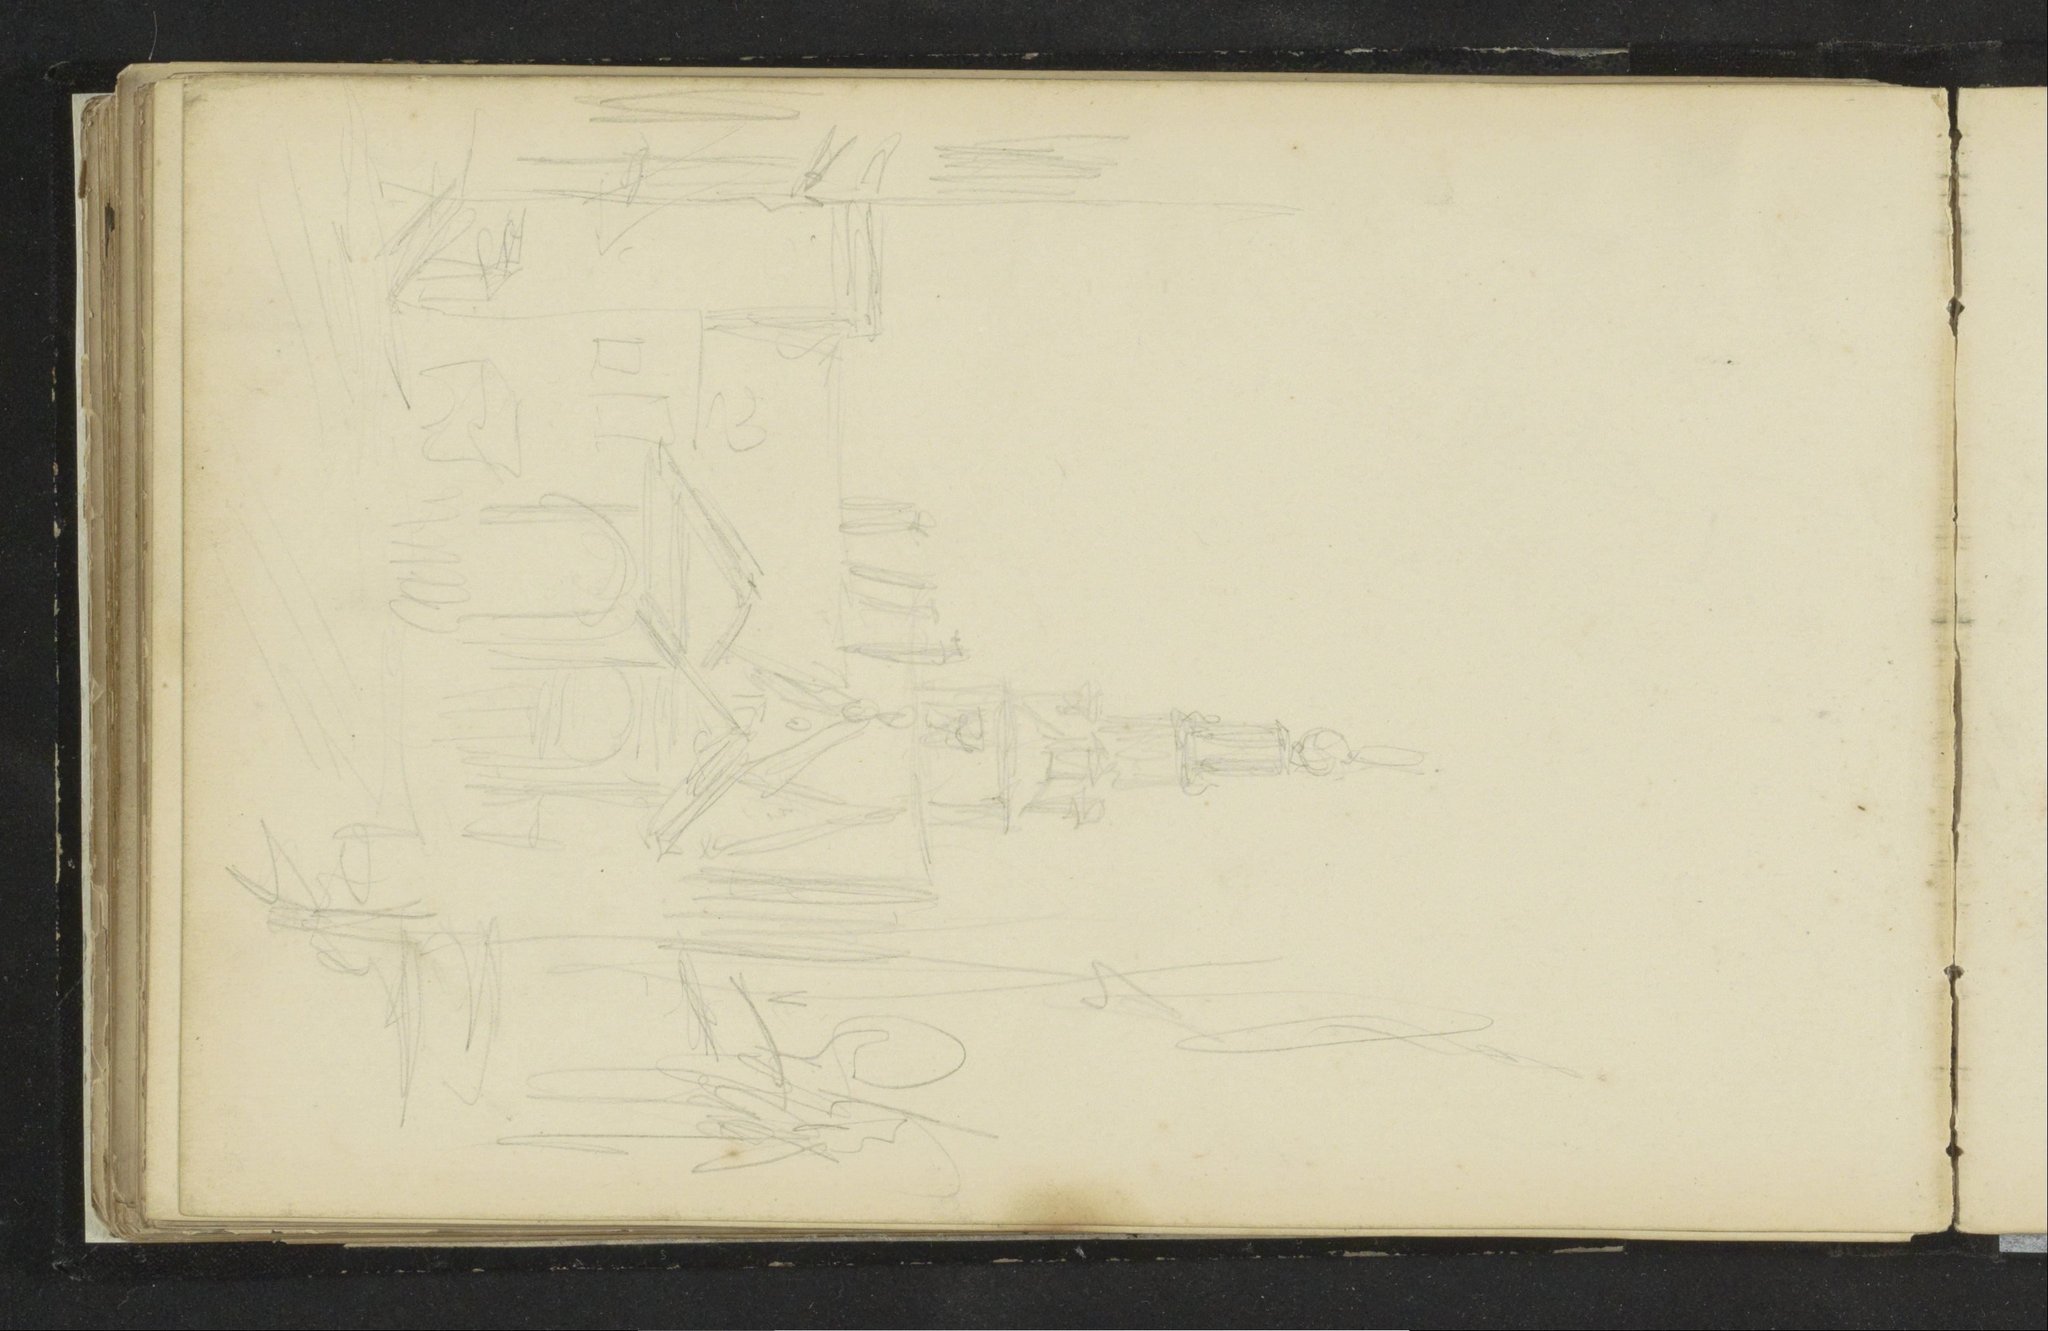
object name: sketchbook leaf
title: Stadsgezicht met een kerktoren, mogelijk in Amsterdam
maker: cornelis springer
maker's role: draughtsman, painter, print maker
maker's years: 1817-1891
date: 1846-1882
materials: paper, pencil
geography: amsterdam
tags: city-view, and landscape with man-made constructions, parts of church exterior and annexes: tower, amsterdam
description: Stadsgezicht met een kerktoren, mogelijk in Amsterdam. Blad 77 verso uit een schetsboek met 91 bladen.